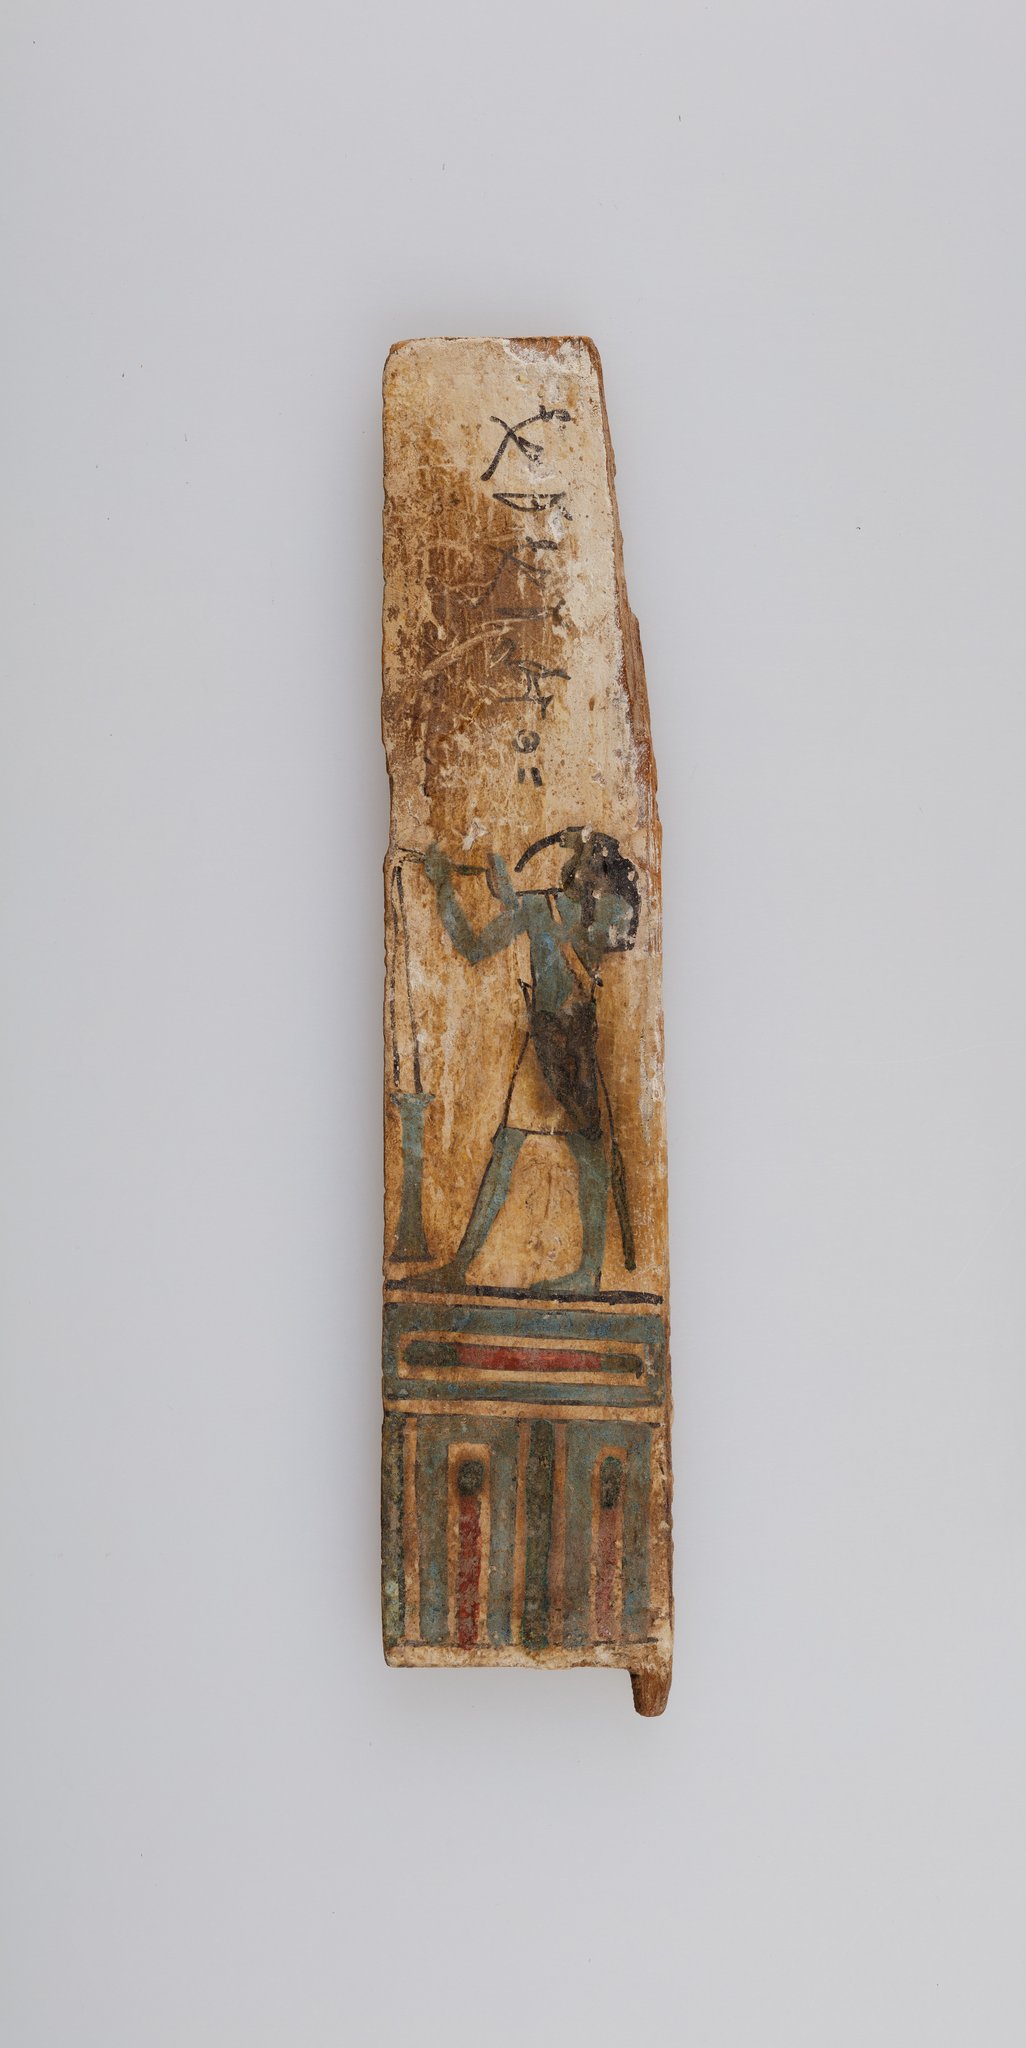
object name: shrine fragment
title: Shrine fragment with a figure of Thoth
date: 760-332 BCE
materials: paint, wood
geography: egypt